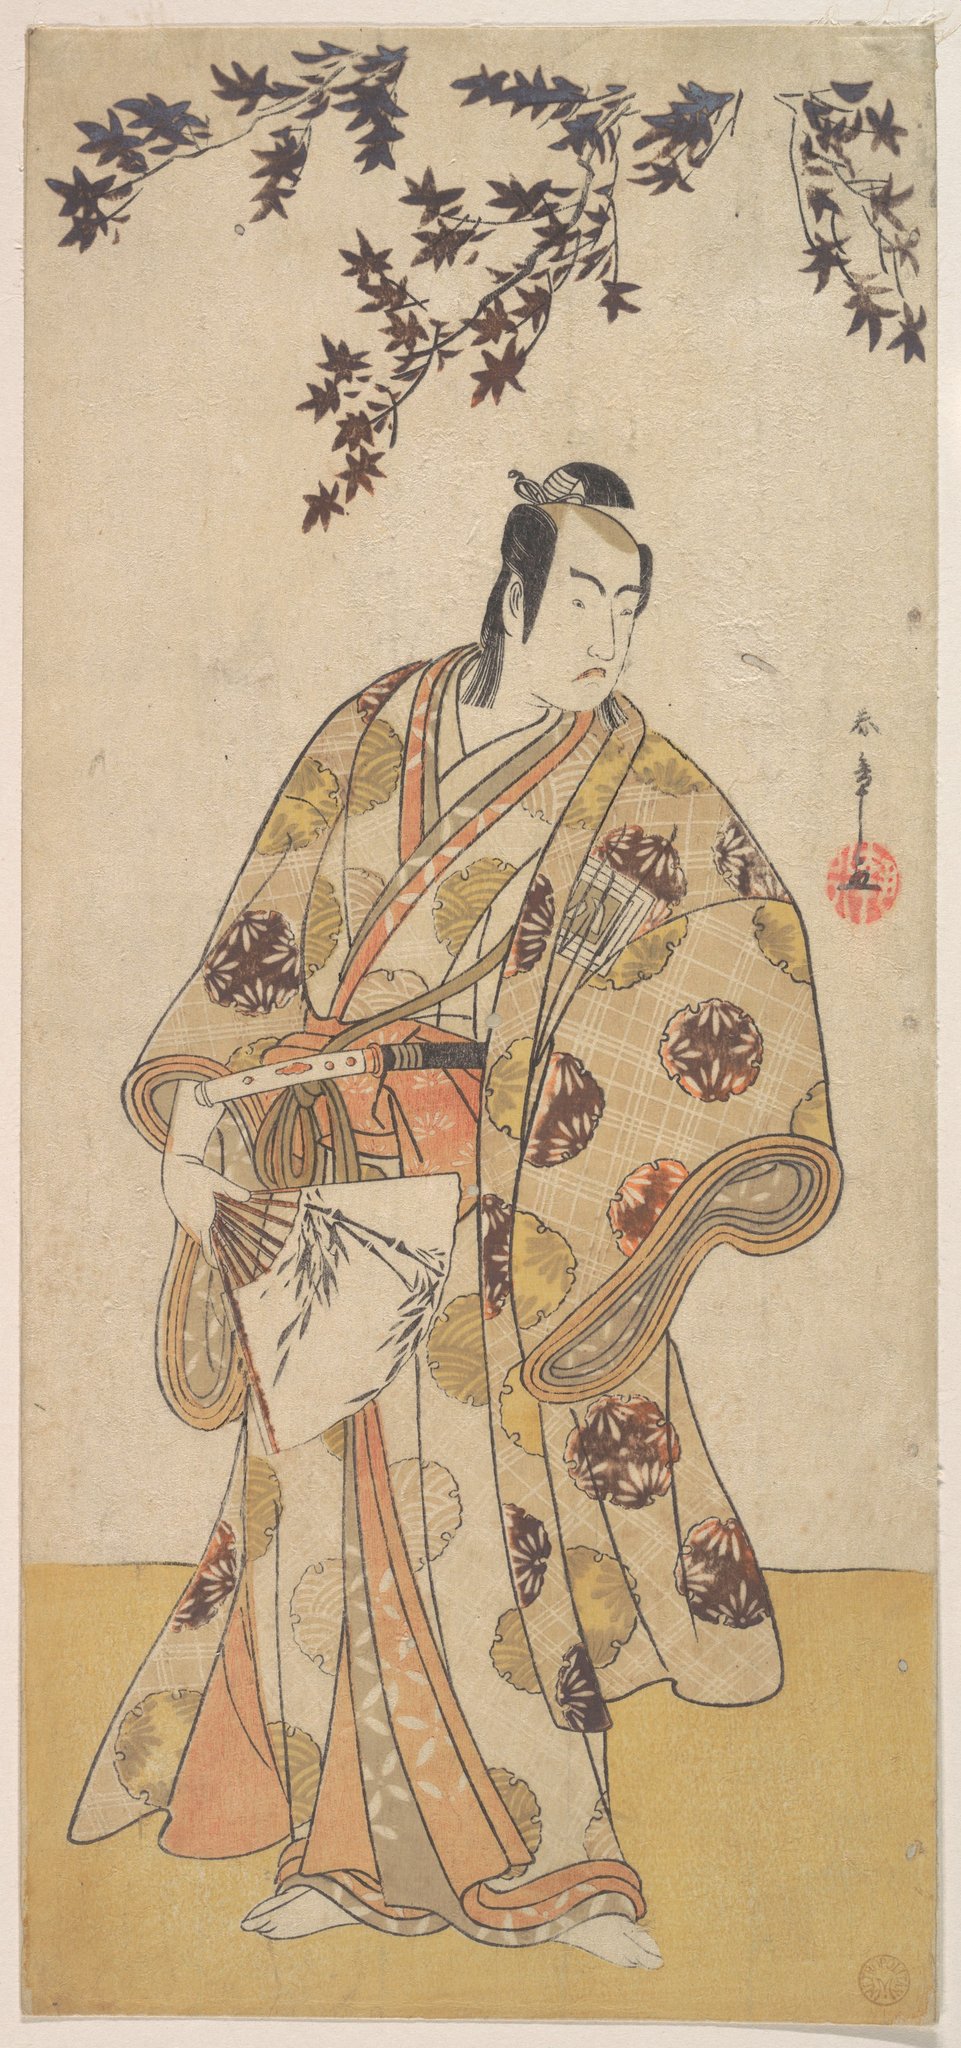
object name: woodblock print nishiki e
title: The Third Ichikawa Yaozō as a Daimyo Standing Under a Maple Tree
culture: japanese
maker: katsukawa shunshō 勝川春章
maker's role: artist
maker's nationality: japanese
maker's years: 1726-1792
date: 1783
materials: ink, paper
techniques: nishiki e, woodblock print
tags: men,leaves,actors